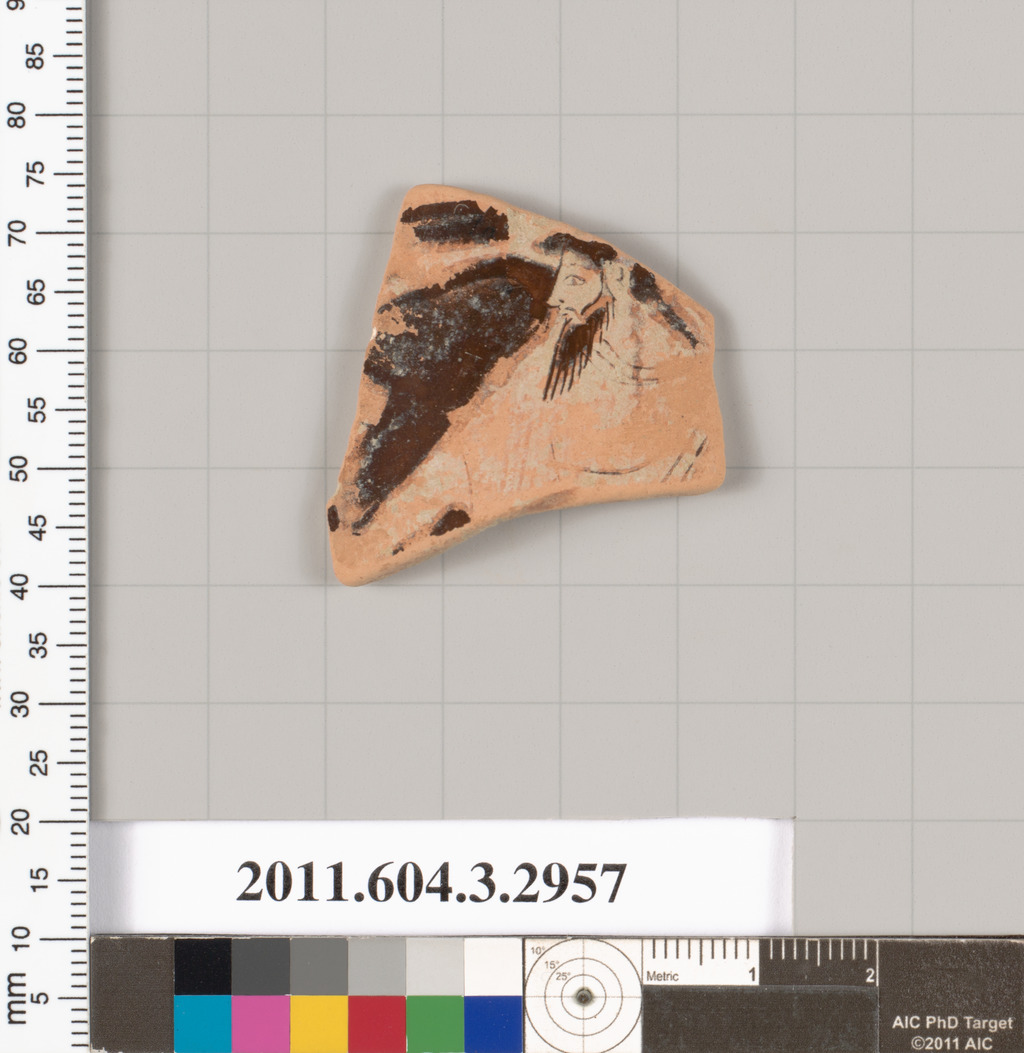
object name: lekythos fragment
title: Terracotta fragment of a lekythos (oil flask)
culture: greek, attic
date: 534-468 BCE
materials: terracotta